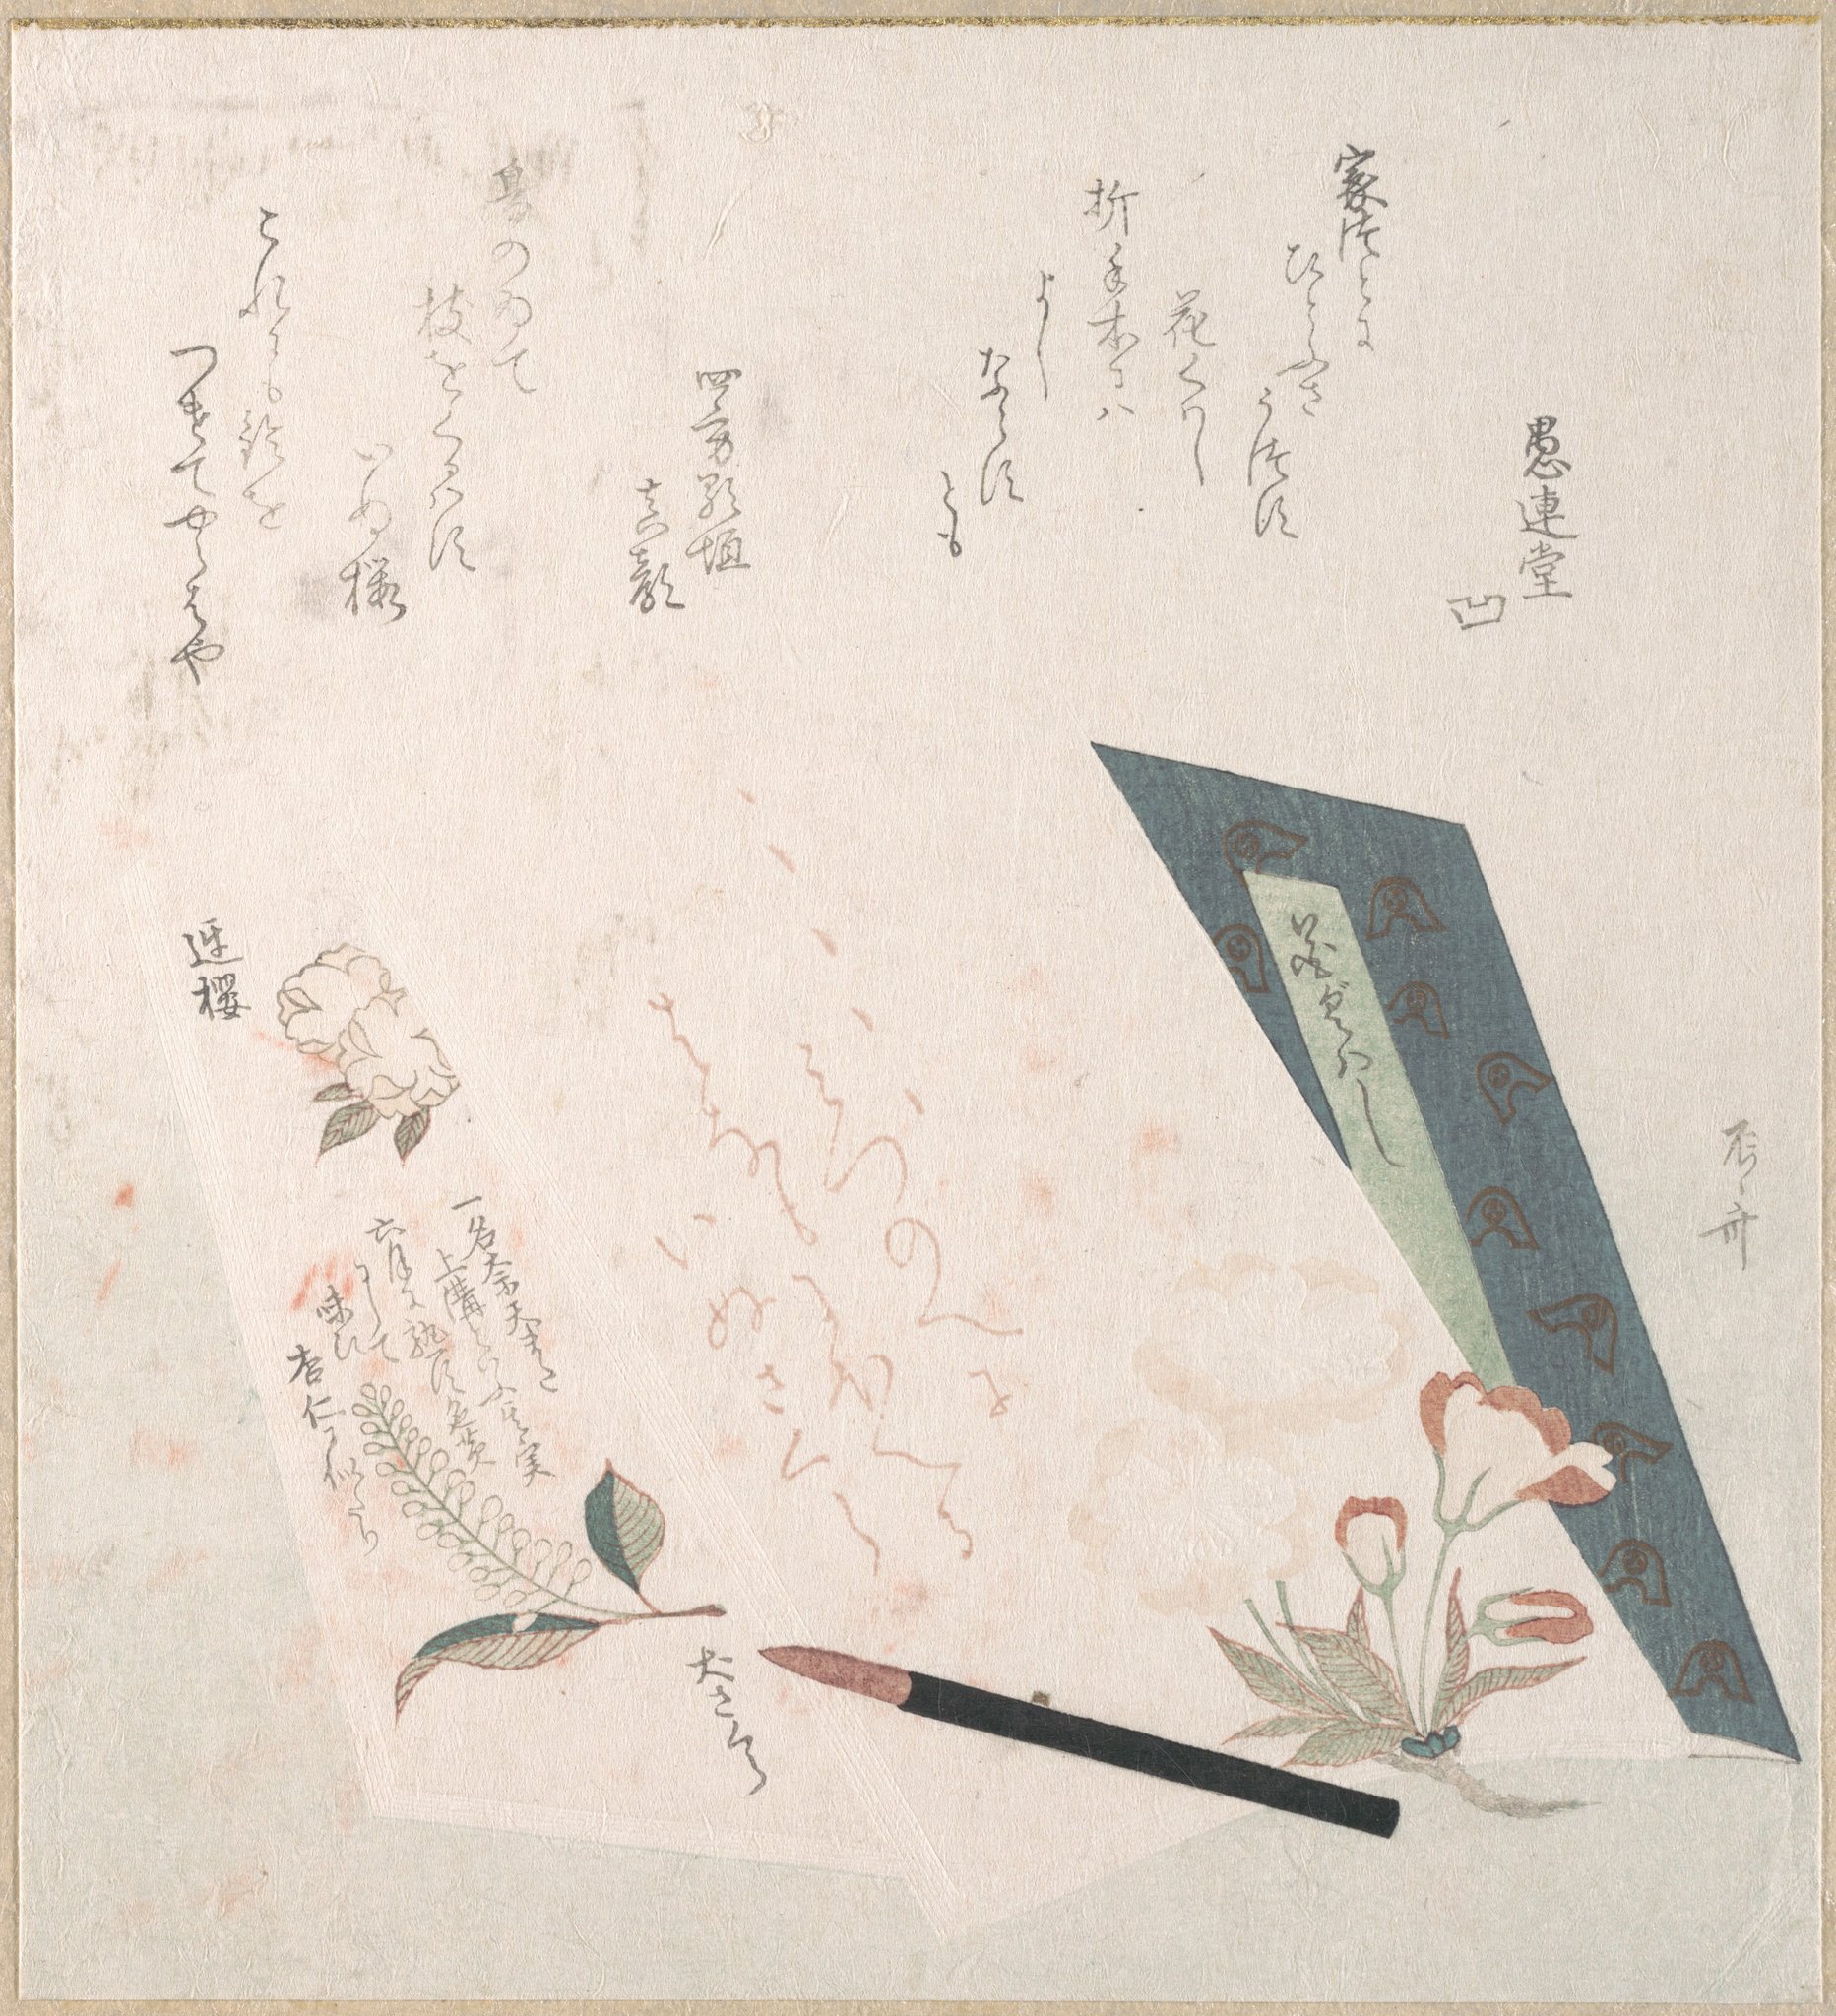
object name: woodblock print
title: Books of Flowers and a Writing Brush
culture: japanese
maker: ryūryūkyo shinsai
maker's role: artist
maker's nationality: japanese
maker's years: 1799-1823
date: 1801-1900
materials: ink, paper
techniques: surimono, woodblock print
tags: flowers,brushes